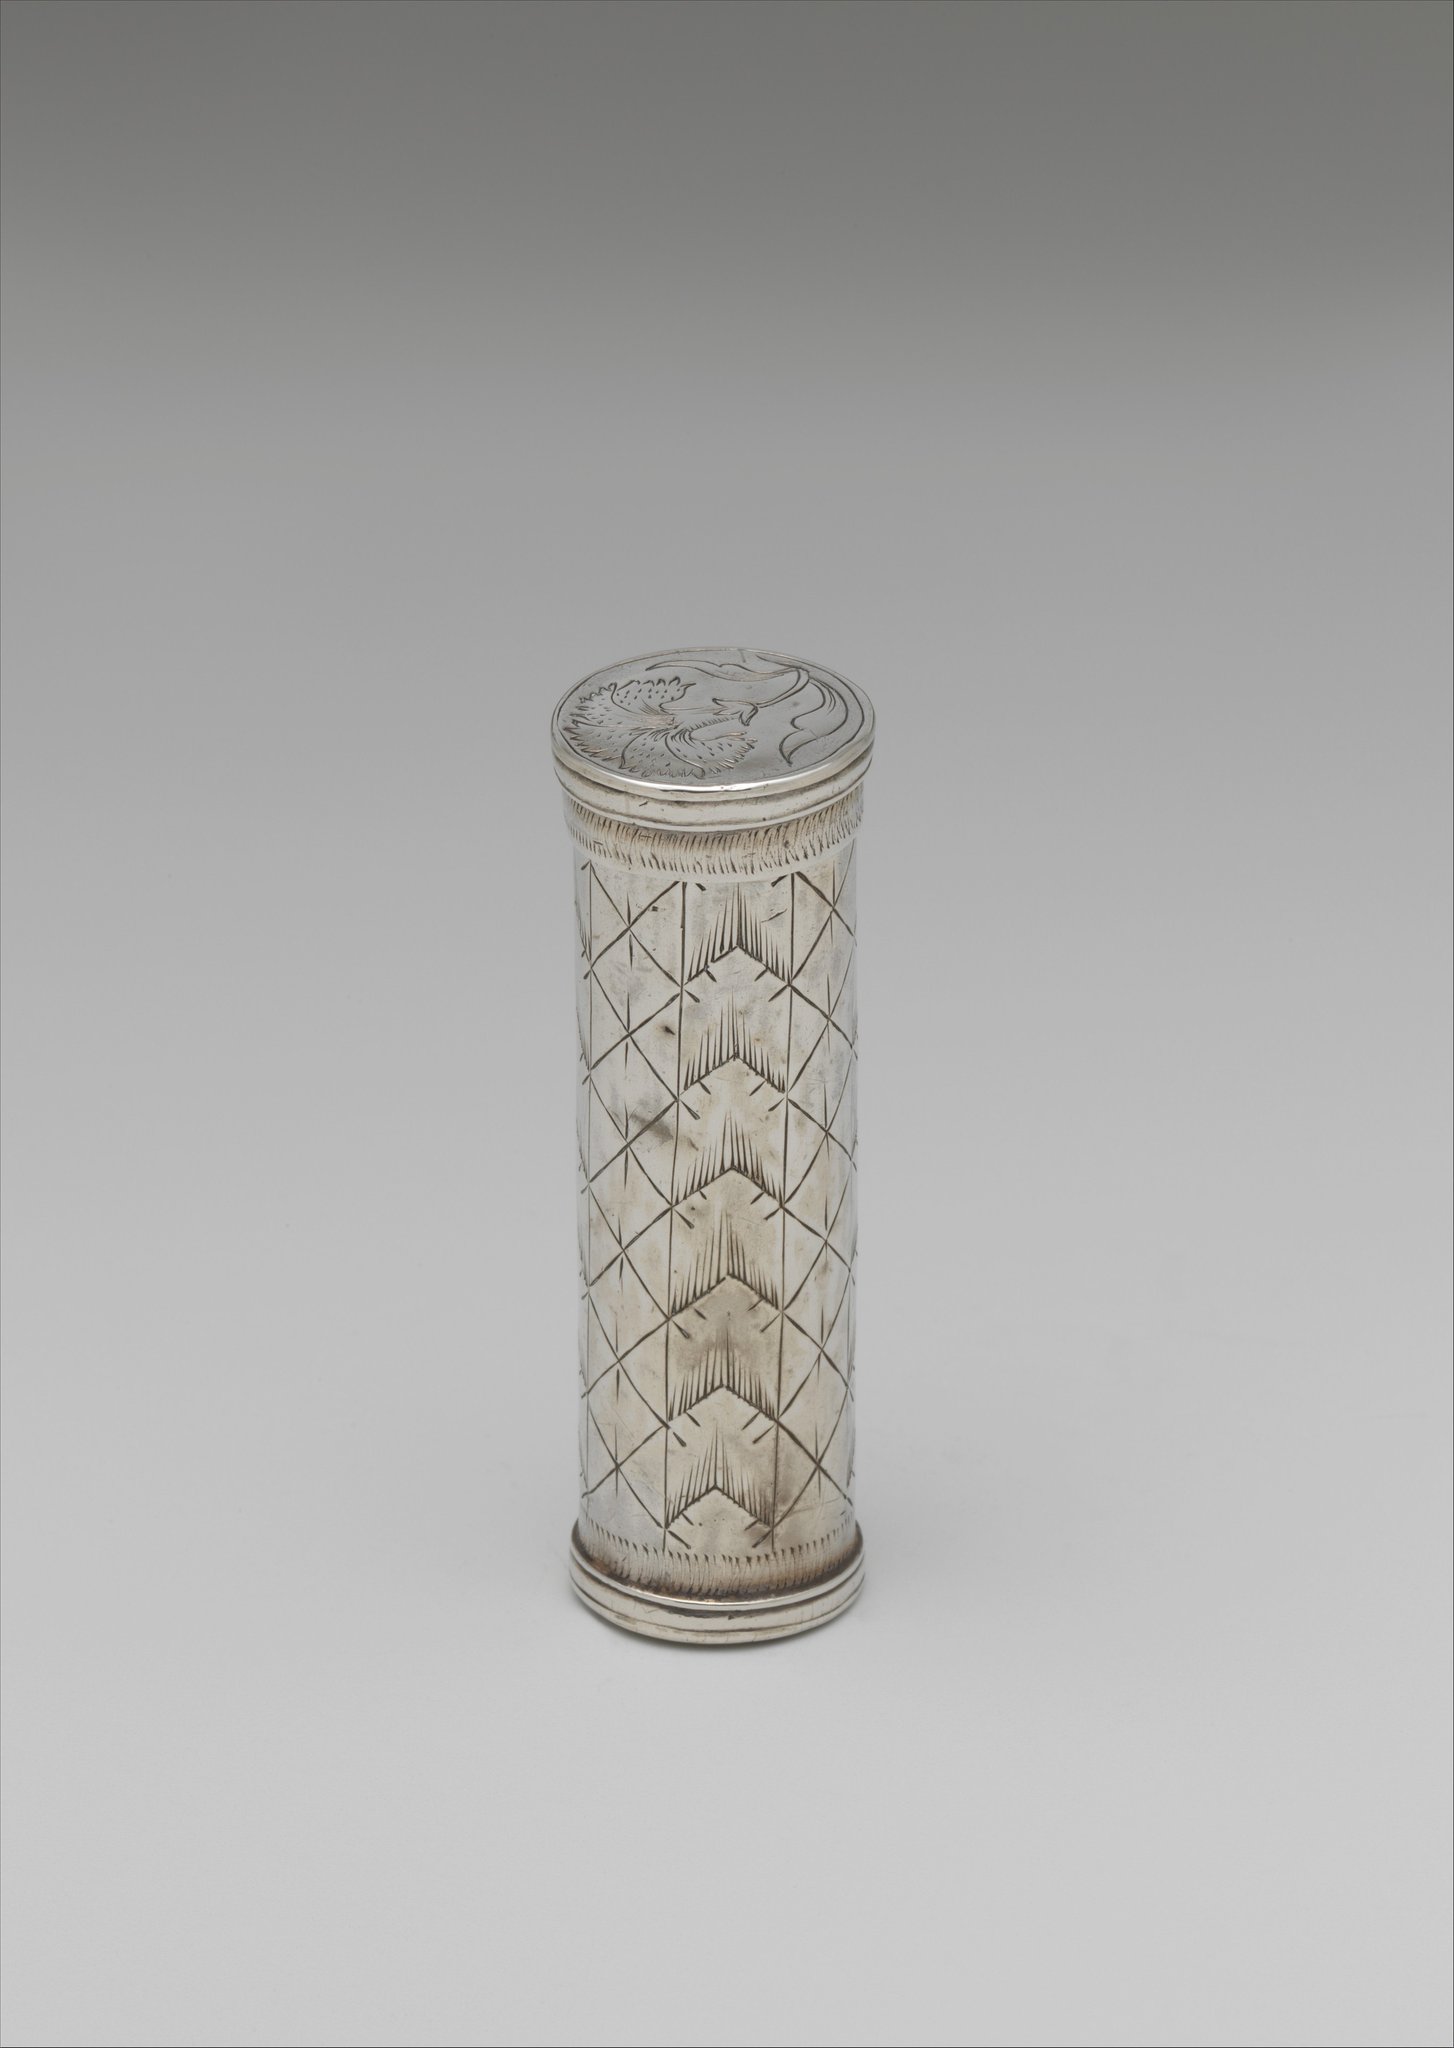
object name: nutmeg grater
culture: american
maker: william cowell sr.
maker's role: maker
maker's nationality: american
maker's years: 1682-1736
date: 1705-1710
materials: silver, steel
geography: united states